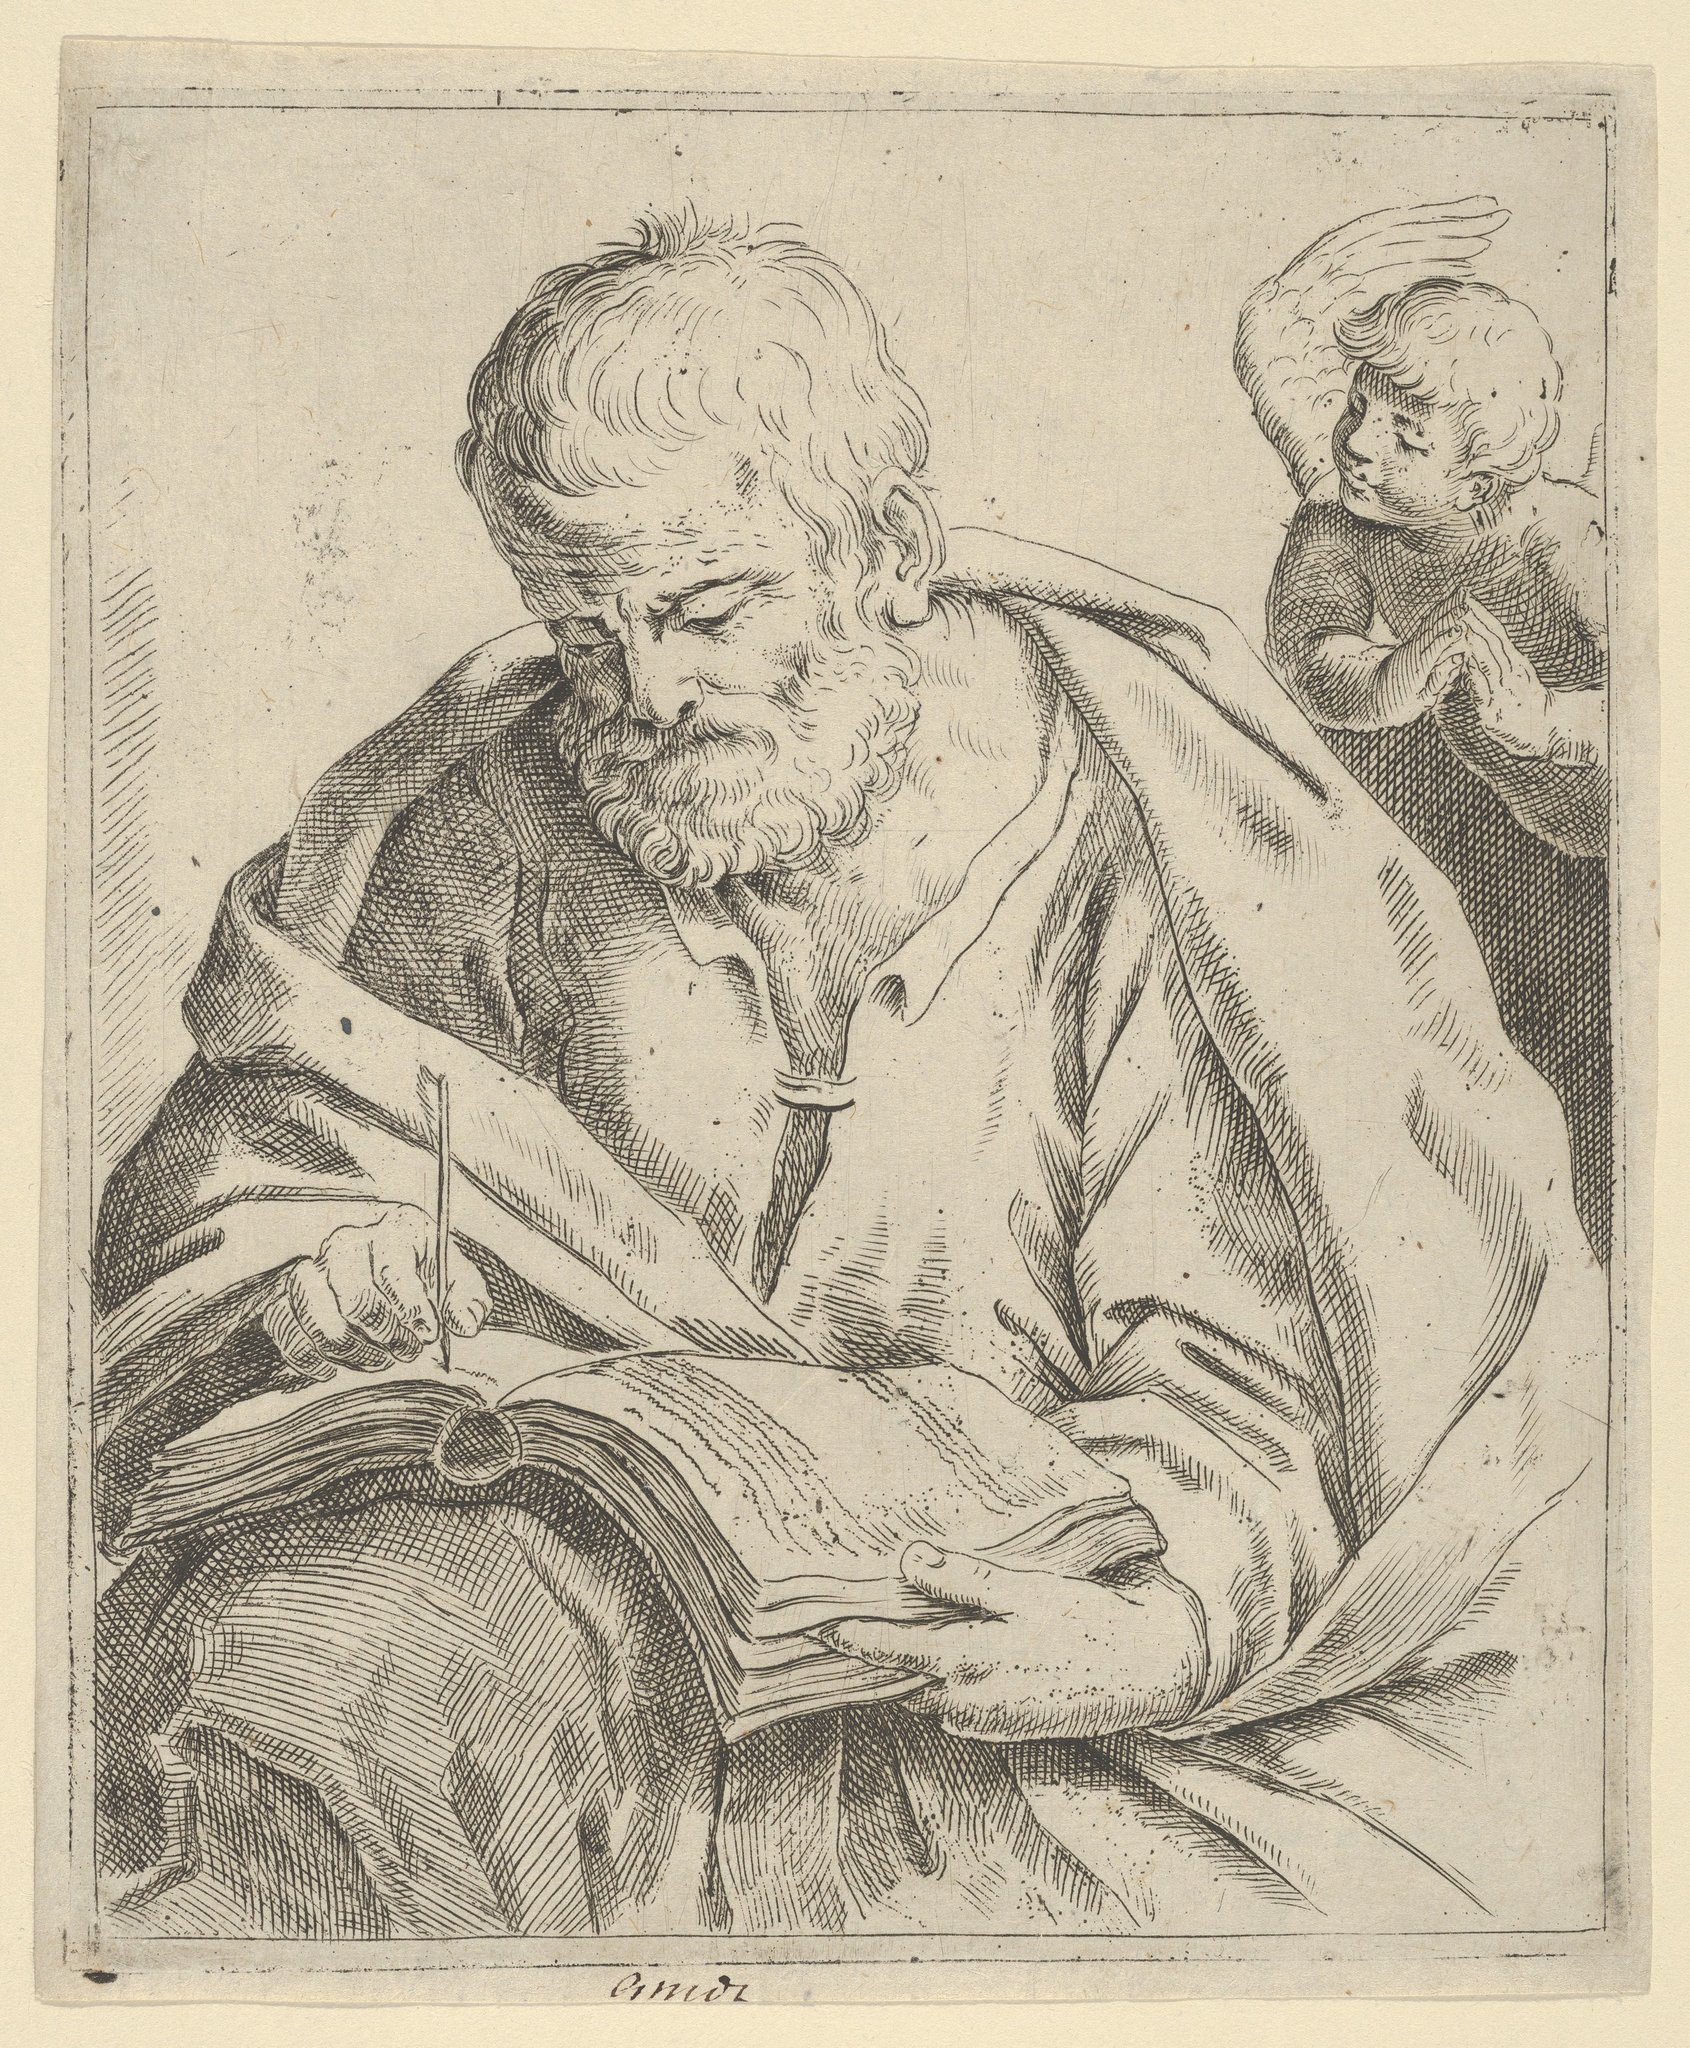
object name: print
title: Old man seated and writing in a book, an angel at right looking over his shoulder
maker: Anonymous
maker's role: artist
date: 1601-1700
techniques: etching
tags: books,men,angels,writing